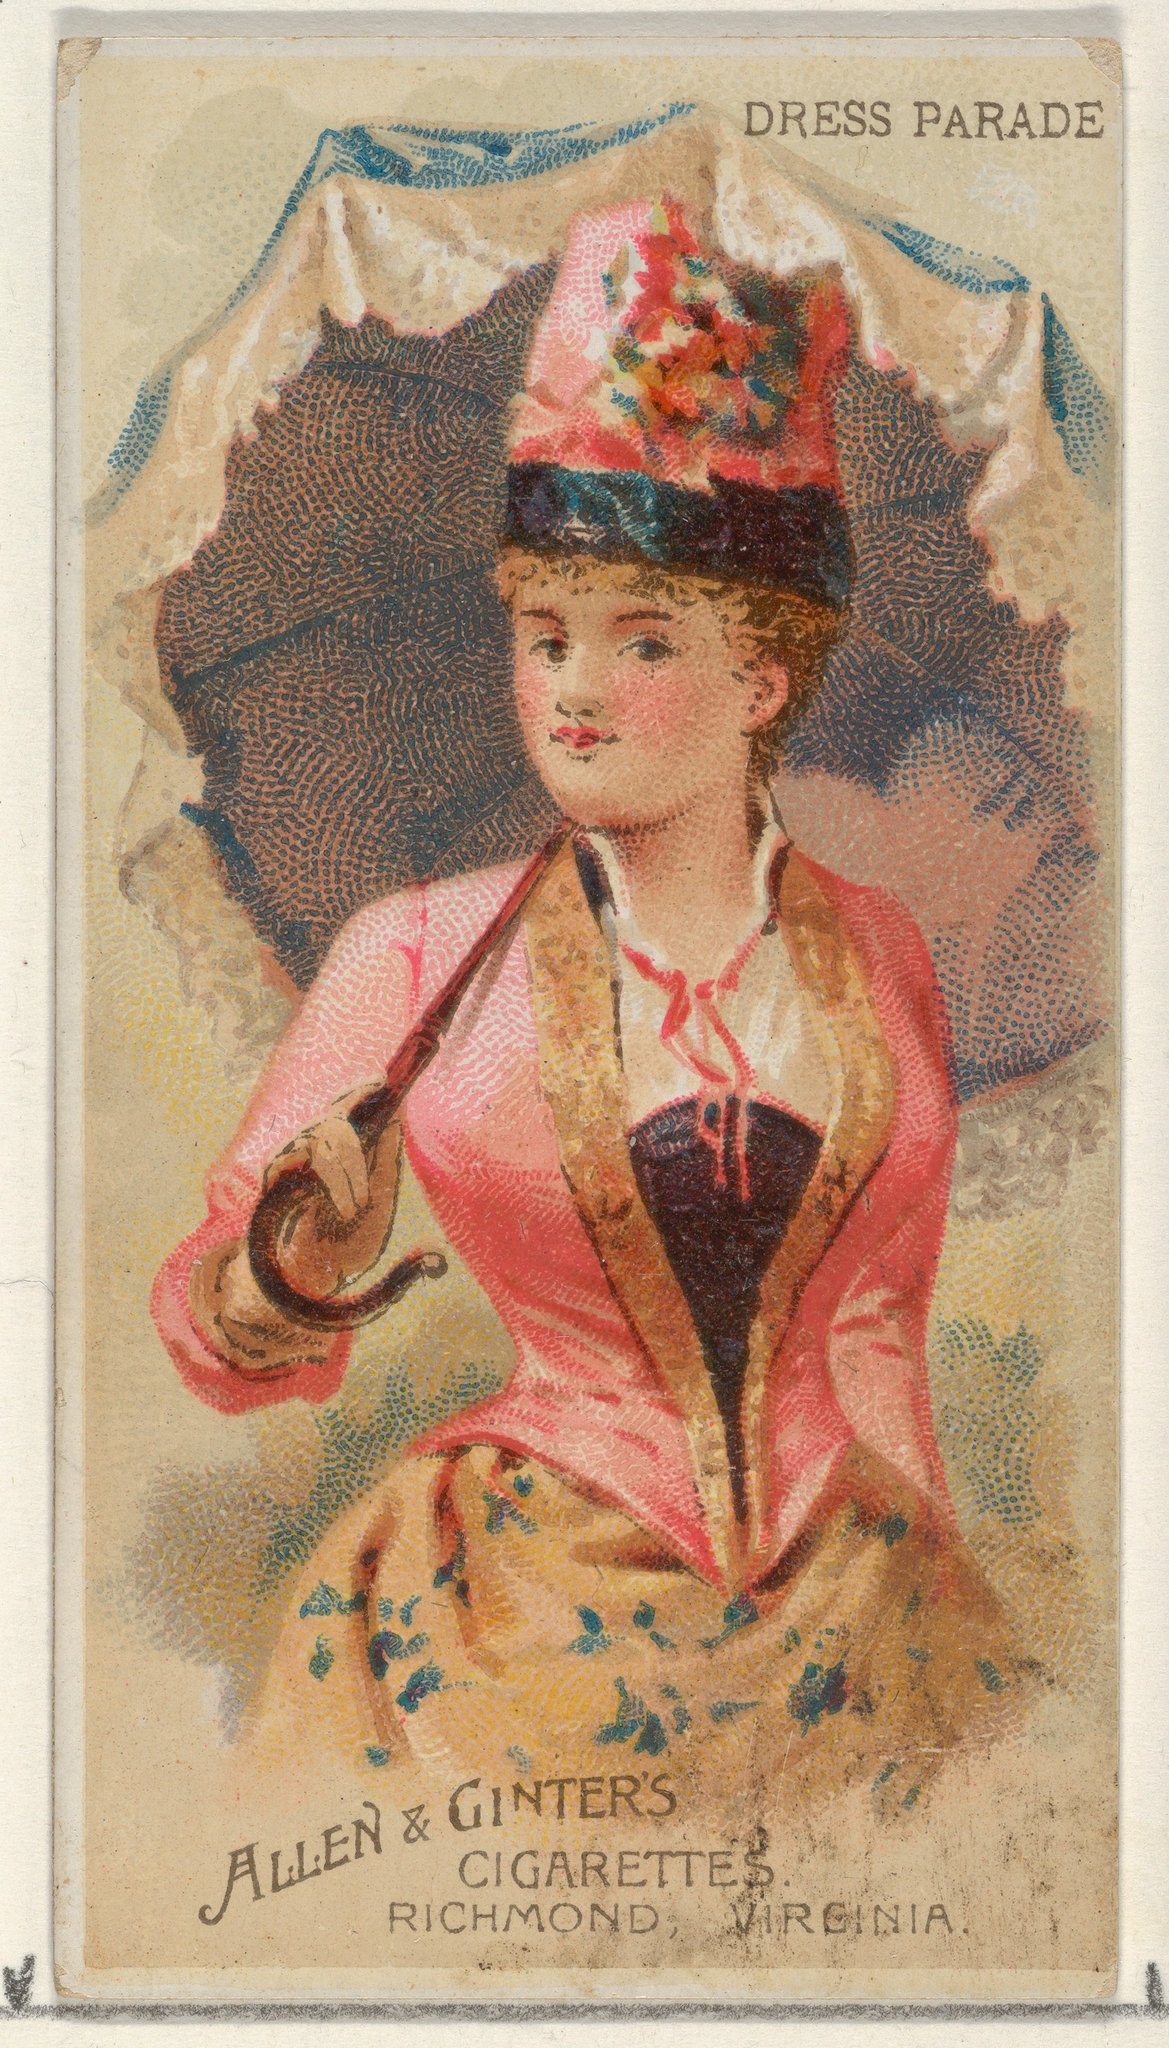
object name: print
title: Dress Parade, from the Parasol Drills series (N18) for Allen & Ginter Cigarettes Brands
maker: allen & ginter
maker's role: publisher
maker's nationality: american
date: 1888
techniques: color lithograph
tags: women